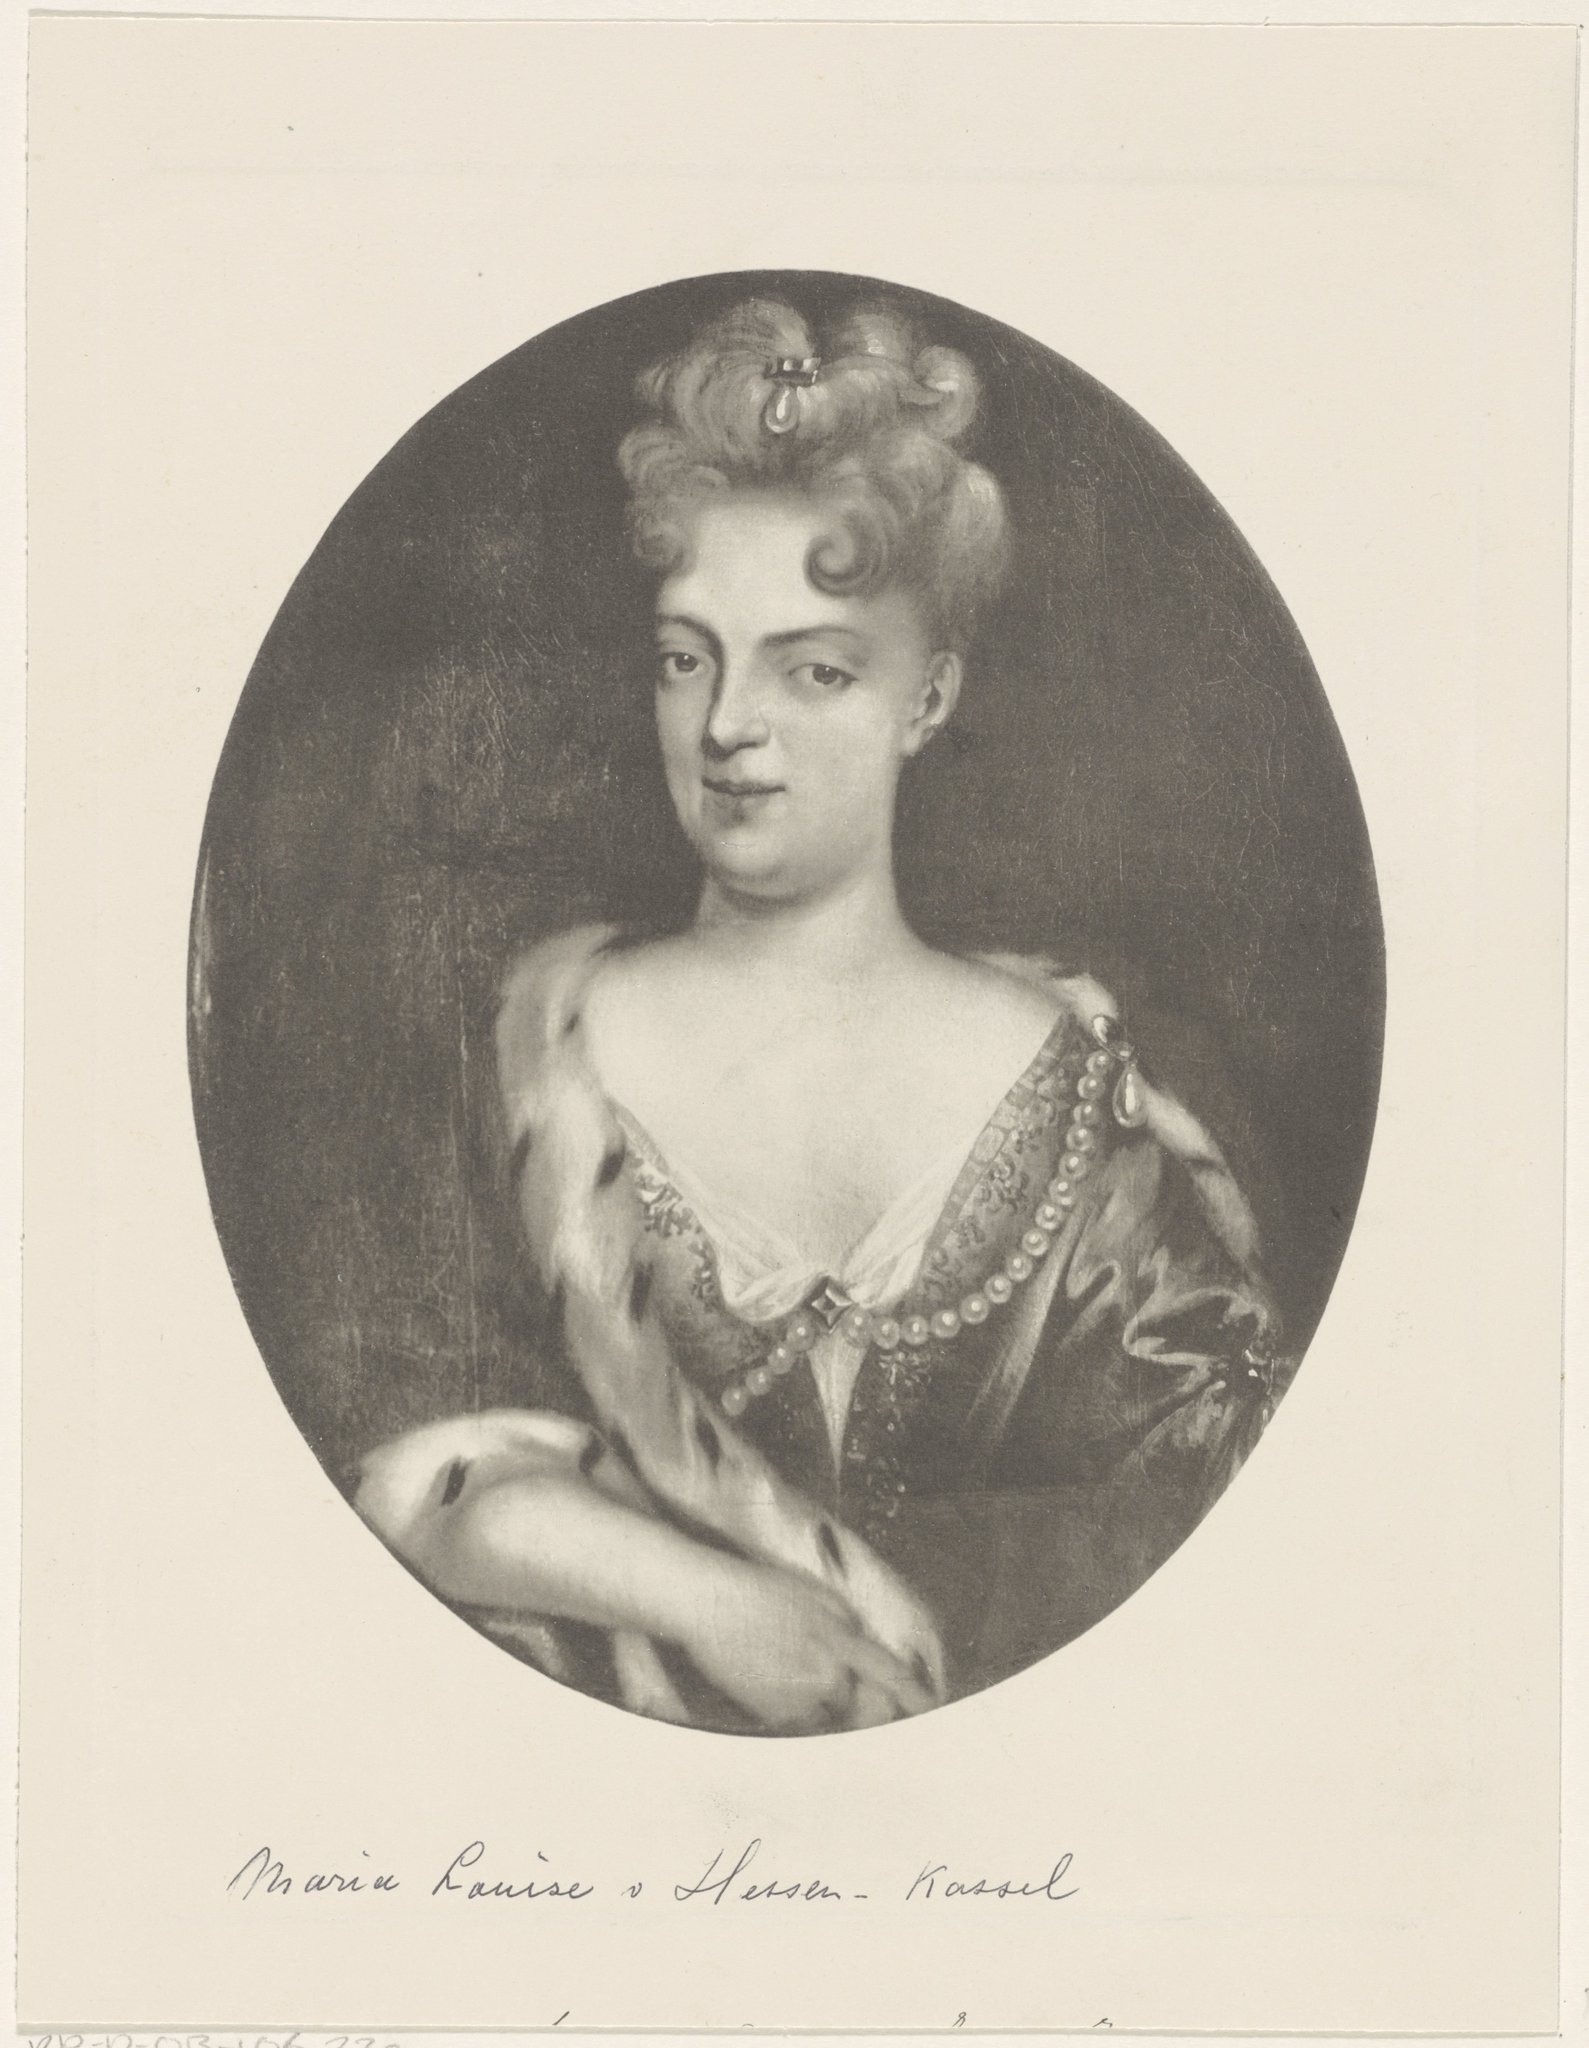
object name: photomechanical print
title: Portret van Maria Louisa van Hessen-Kassel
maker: Anonymous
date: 1850-1949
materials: paper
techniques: photograph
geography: netherlands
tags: kassel, leeuwarden, maria louisa van hessen-kassel